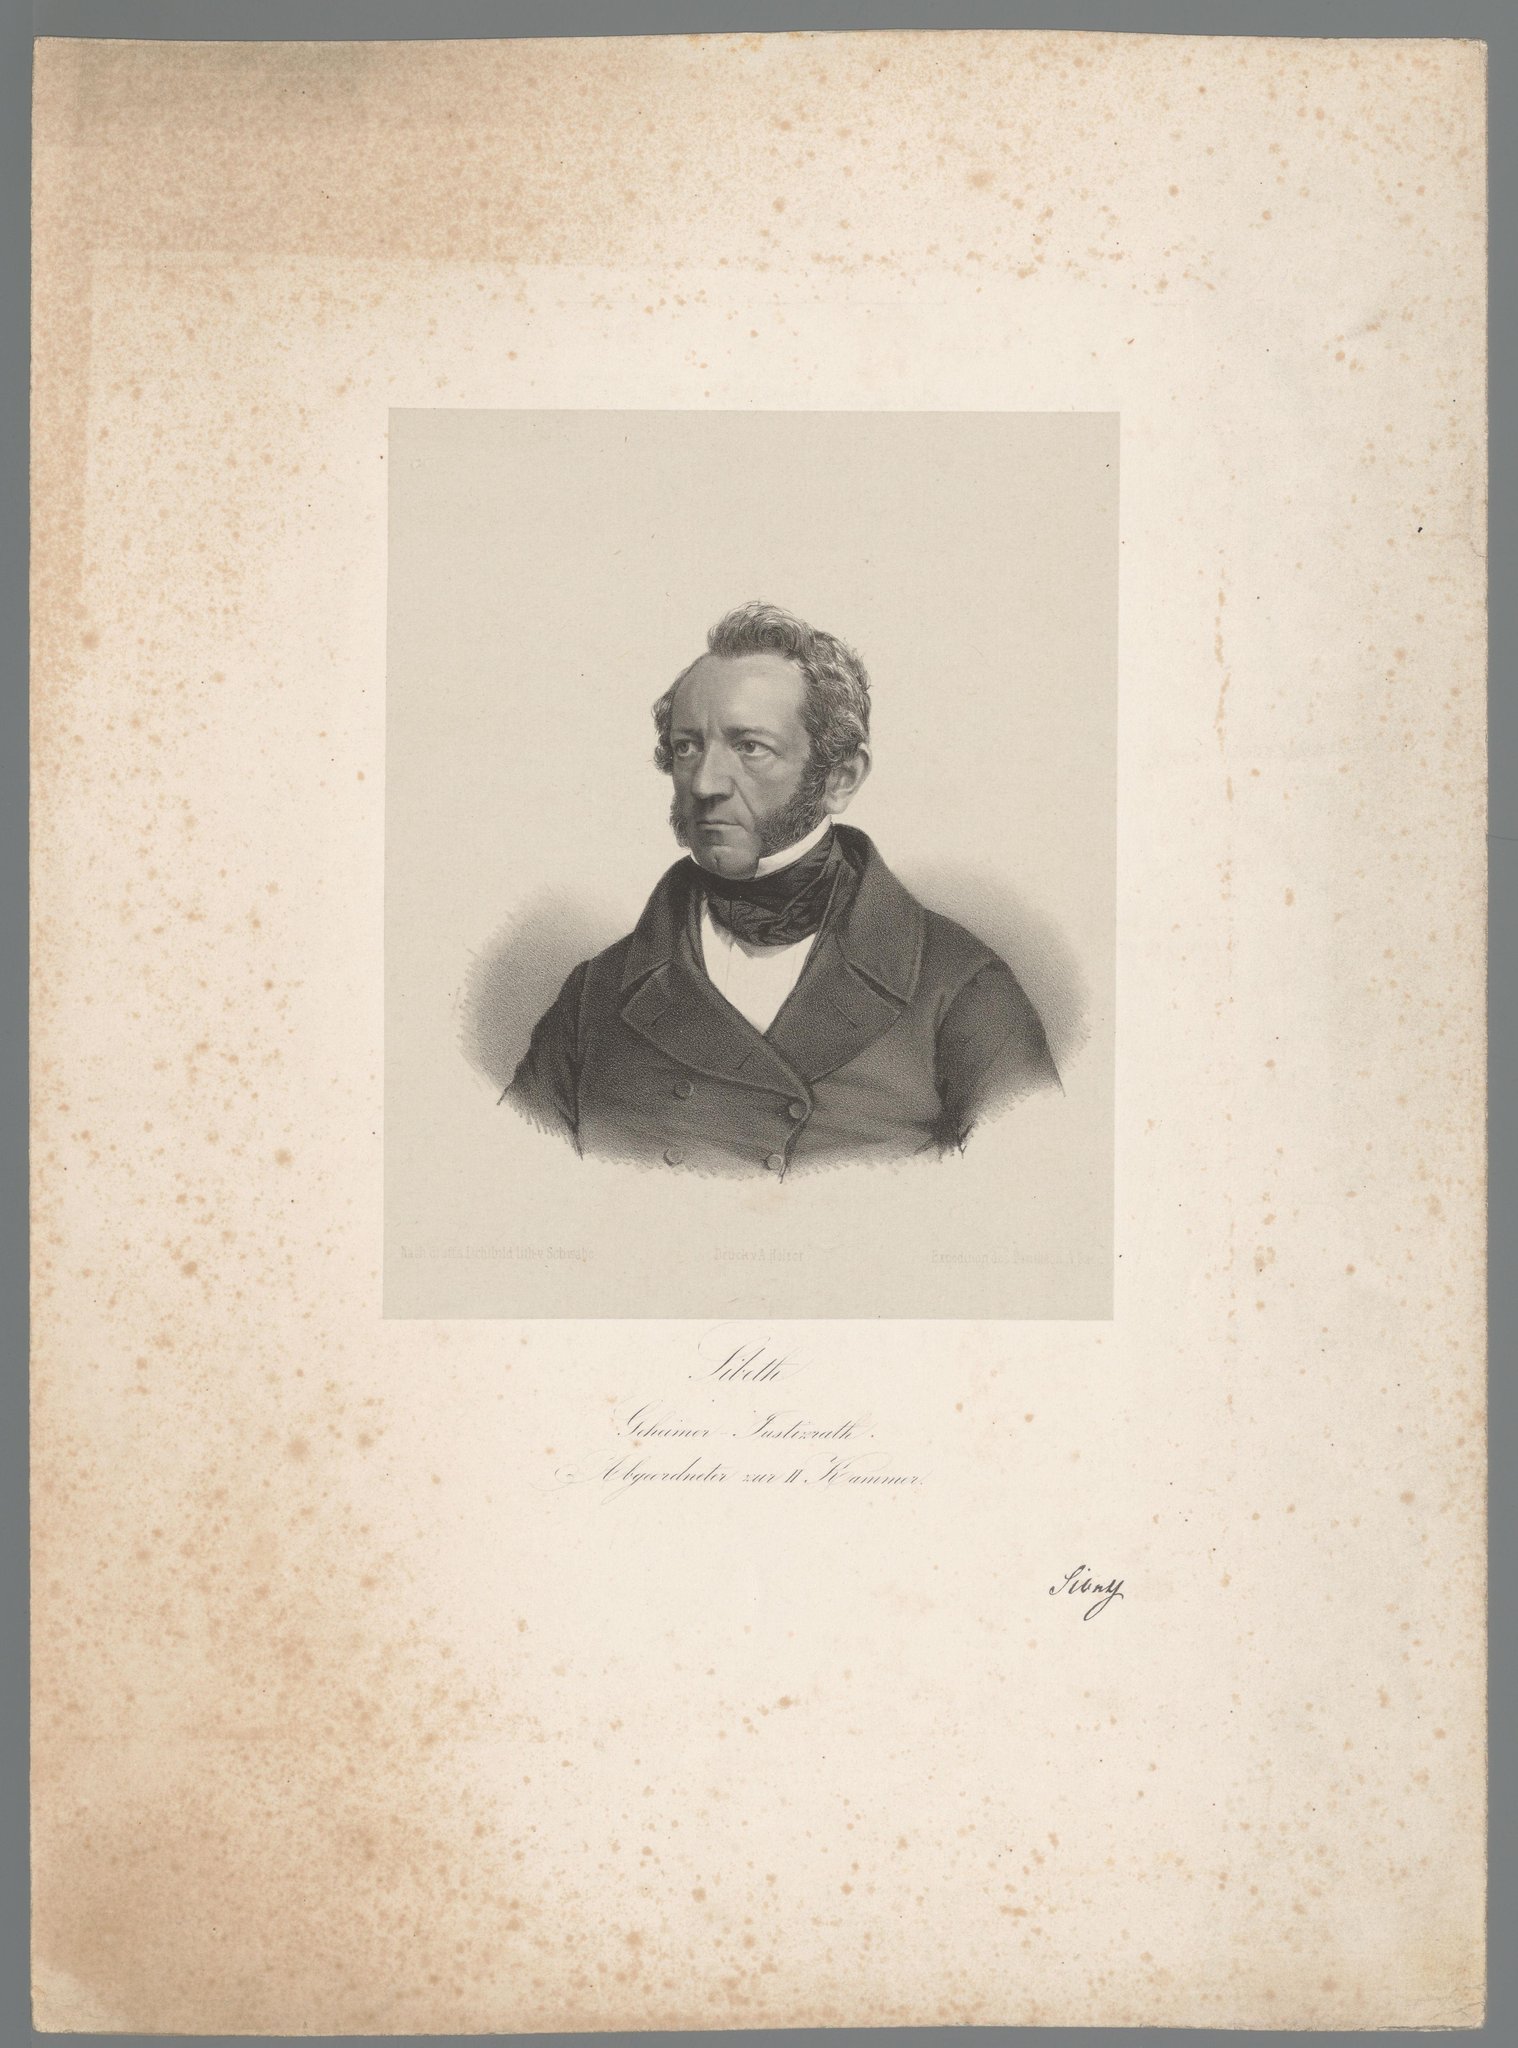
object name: print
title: Sibeth, Geheimer Justizrath, Abgeordneter zur II Kammer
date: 1830-1860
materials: paper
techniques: lithograph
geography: berlin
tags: adult man, historical persons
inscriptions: collector's mark: Lugt 2228